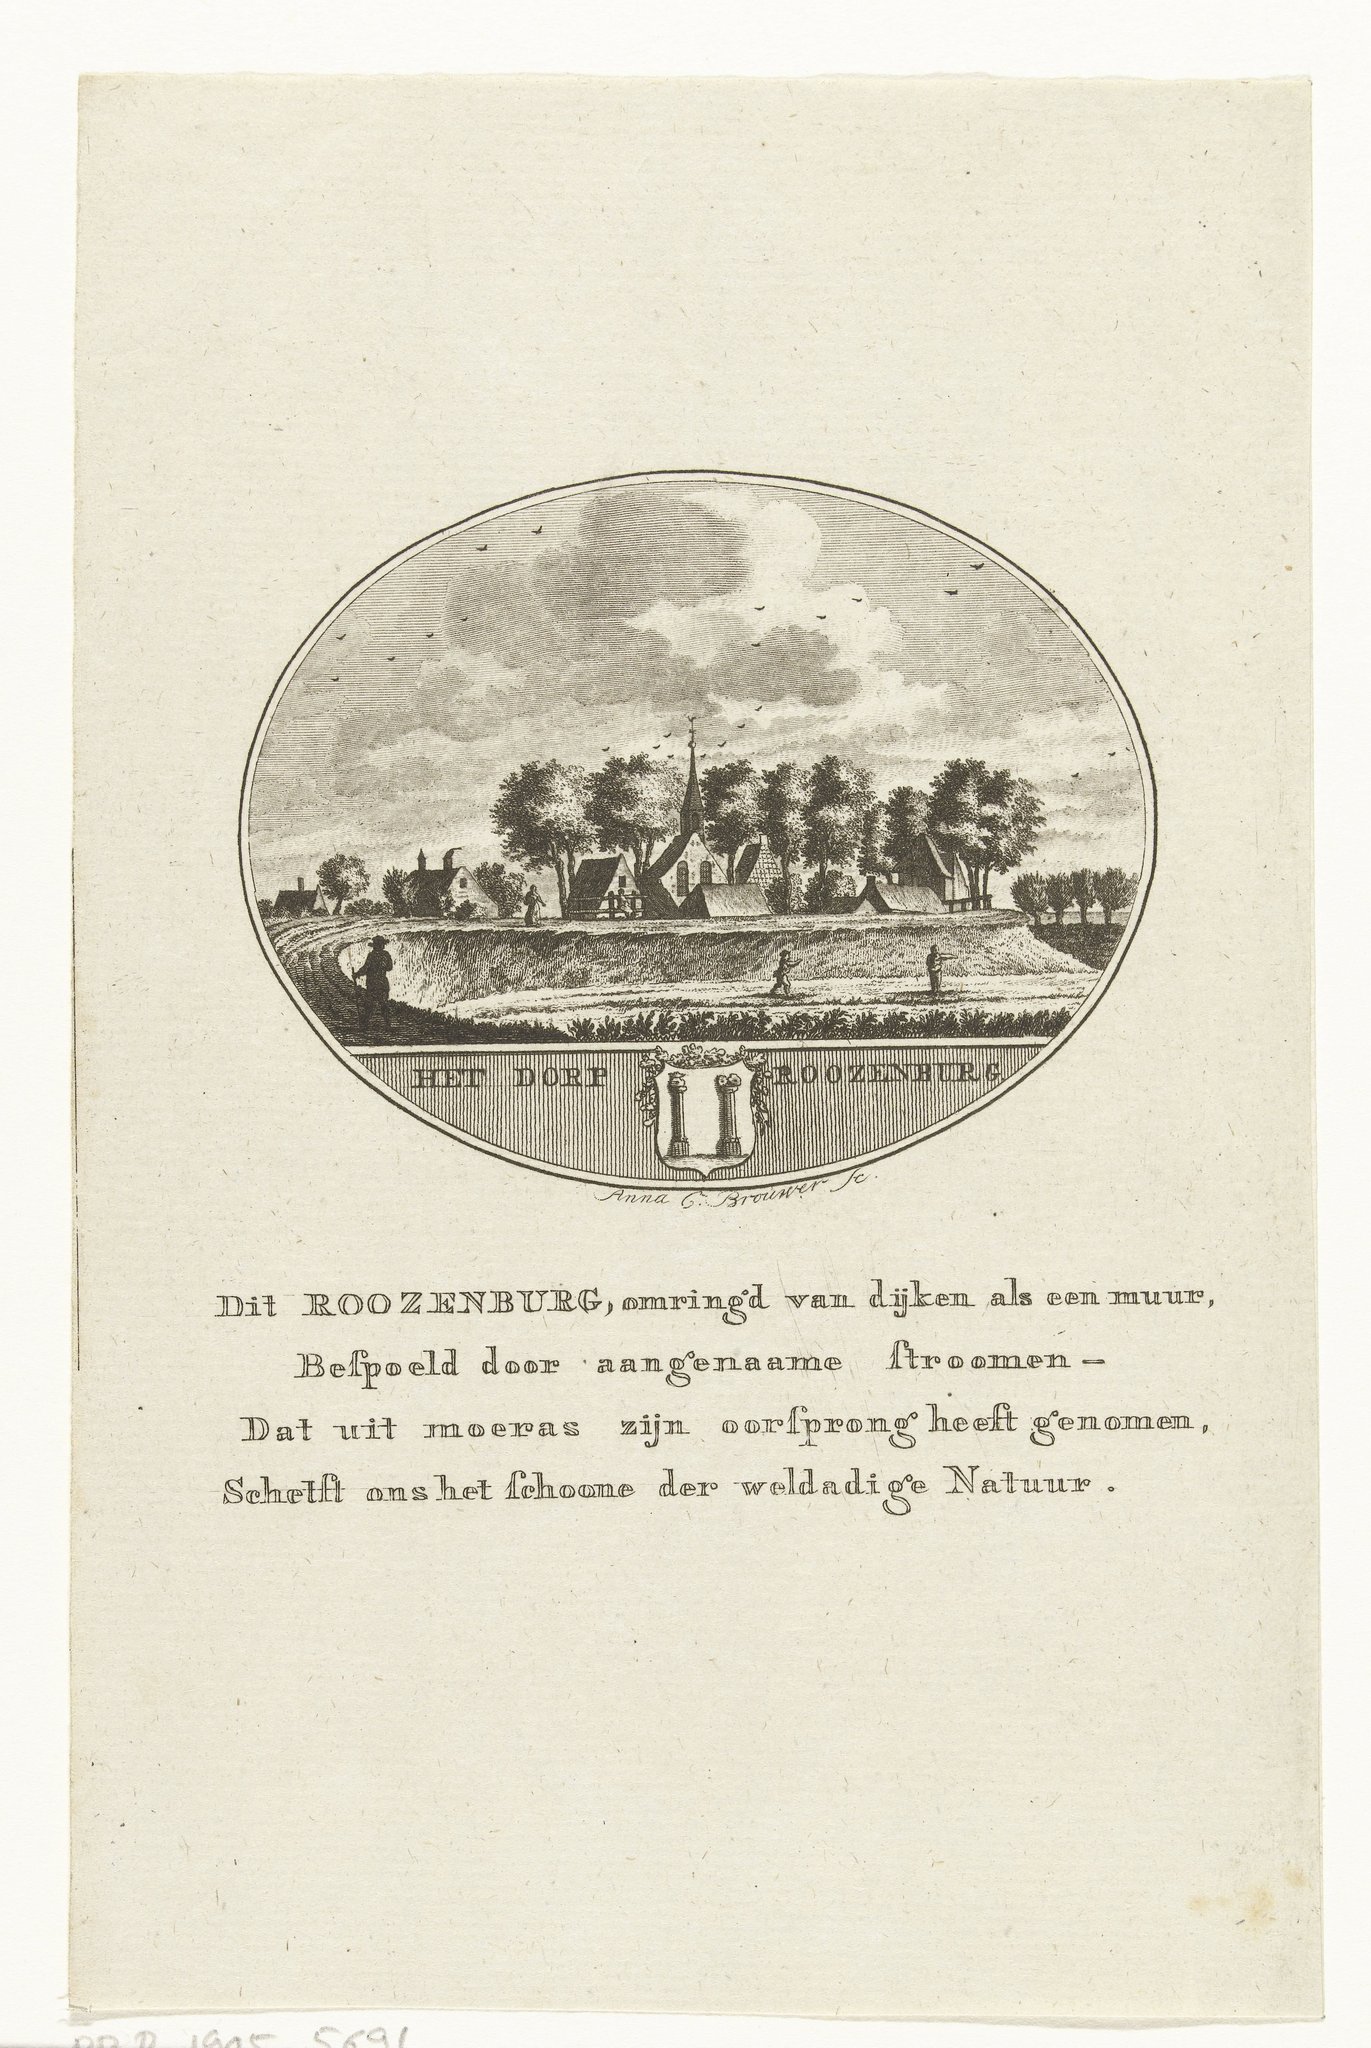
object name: print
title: Het dorp Roozenburg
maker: anna catharina brouwer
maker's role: print maker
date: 1796-1798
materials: paper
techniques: etching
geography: amsterdam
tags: city-view in general; 'veduta'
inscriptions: collector's mark: Lugt 2228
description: afkomstig uit: L. van Ollefen, De Nederlandsche stad- en dorpbeschrijver. Deel 6. Amsterdam: H.A. Banse, 1798.